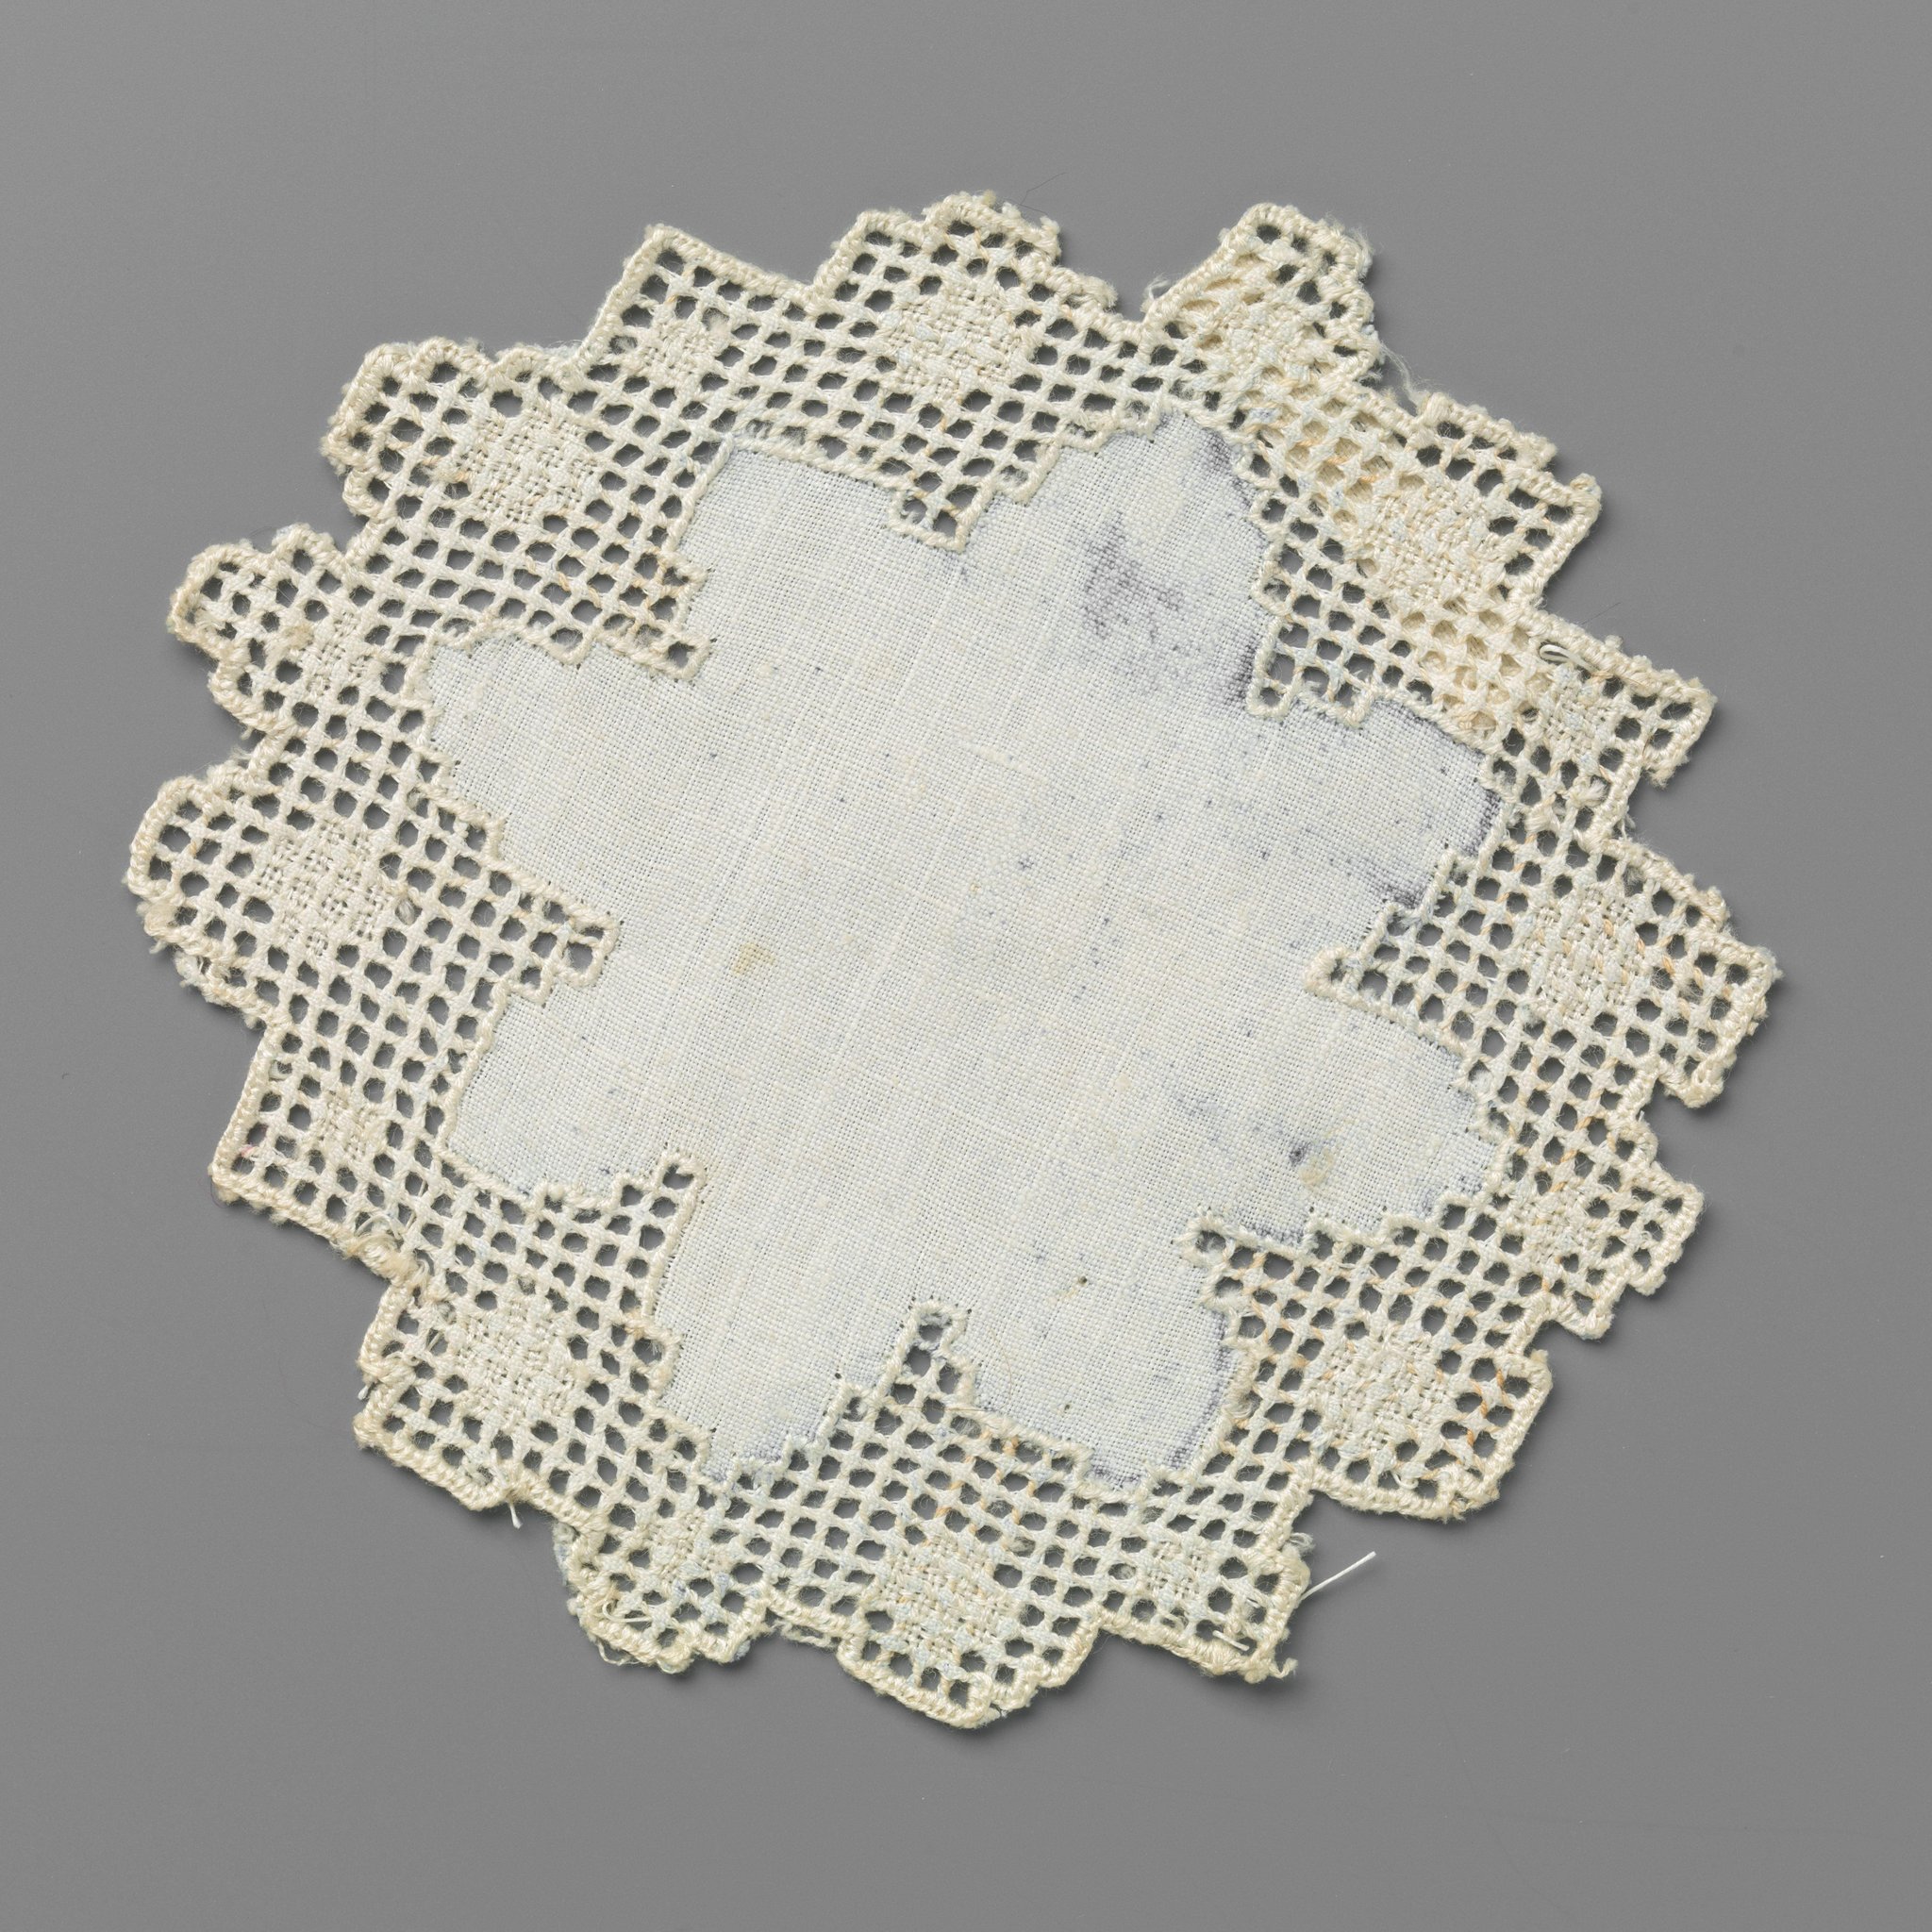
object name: kleed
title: Kleedje van kantborduurwerk met achtpuntig binnenstuk en ronde schulpenrand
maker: Anonymous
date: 1925-1949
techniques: lace embroidery, work with drawn threads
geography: china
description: Kleedje van batist met rondom een rand kantborduurwerk: werk met uitgetrokken draden. Rond model met schulpenrand, het batisten binnenstuk heeft de vorm van een achtpuntige ster of bloem.